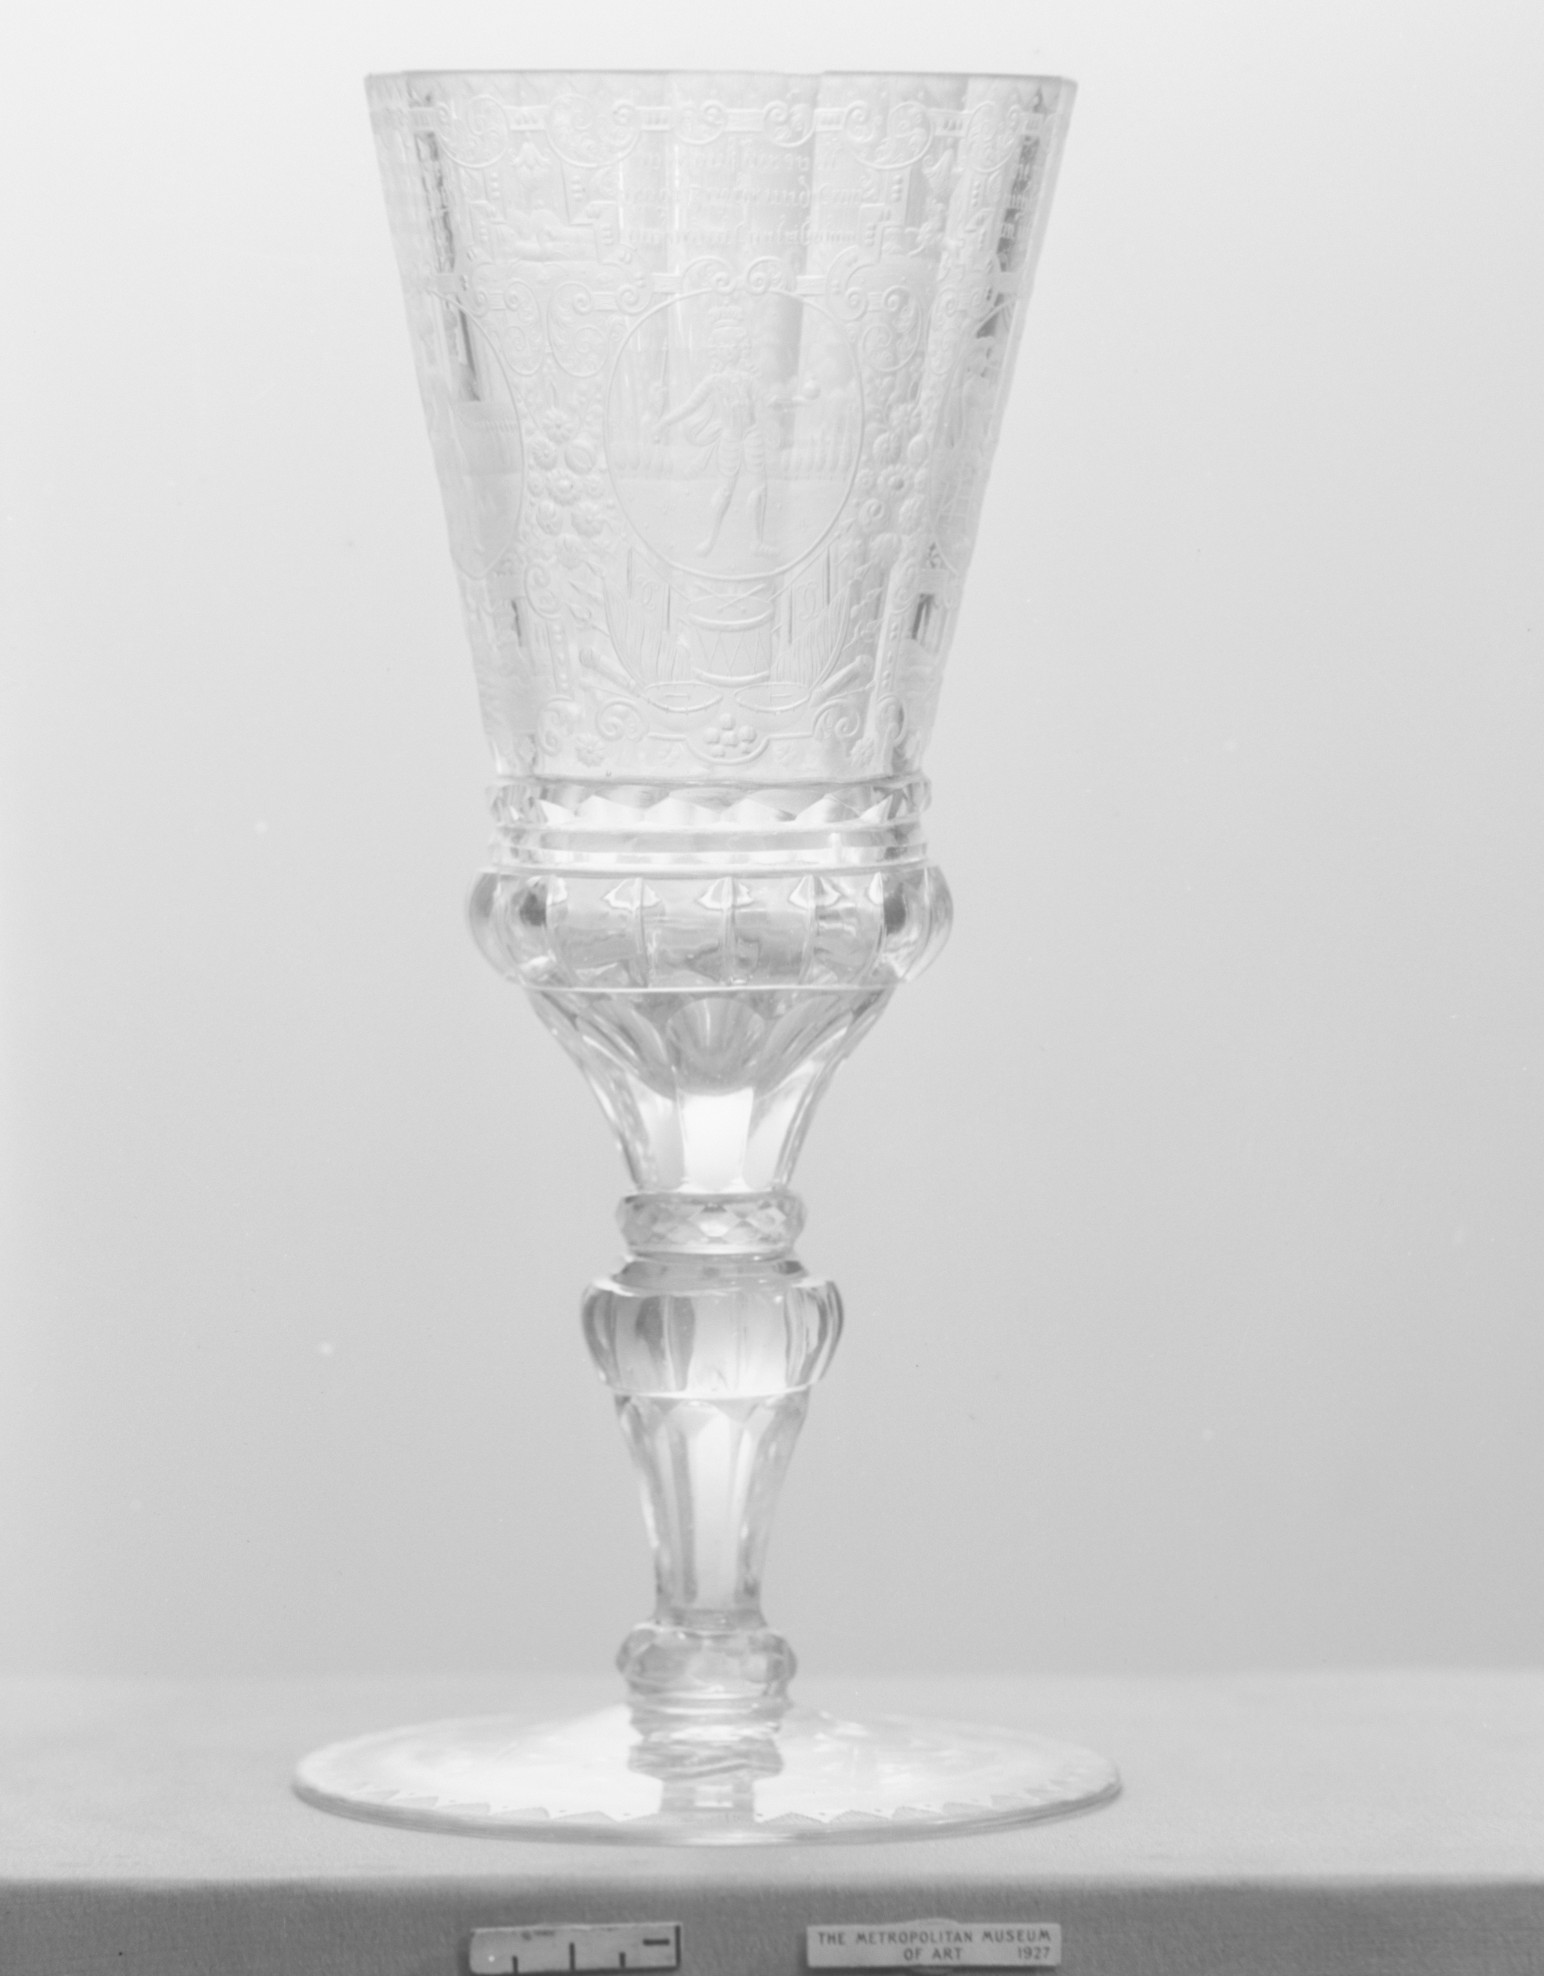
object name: standing cup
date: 1735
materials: glass